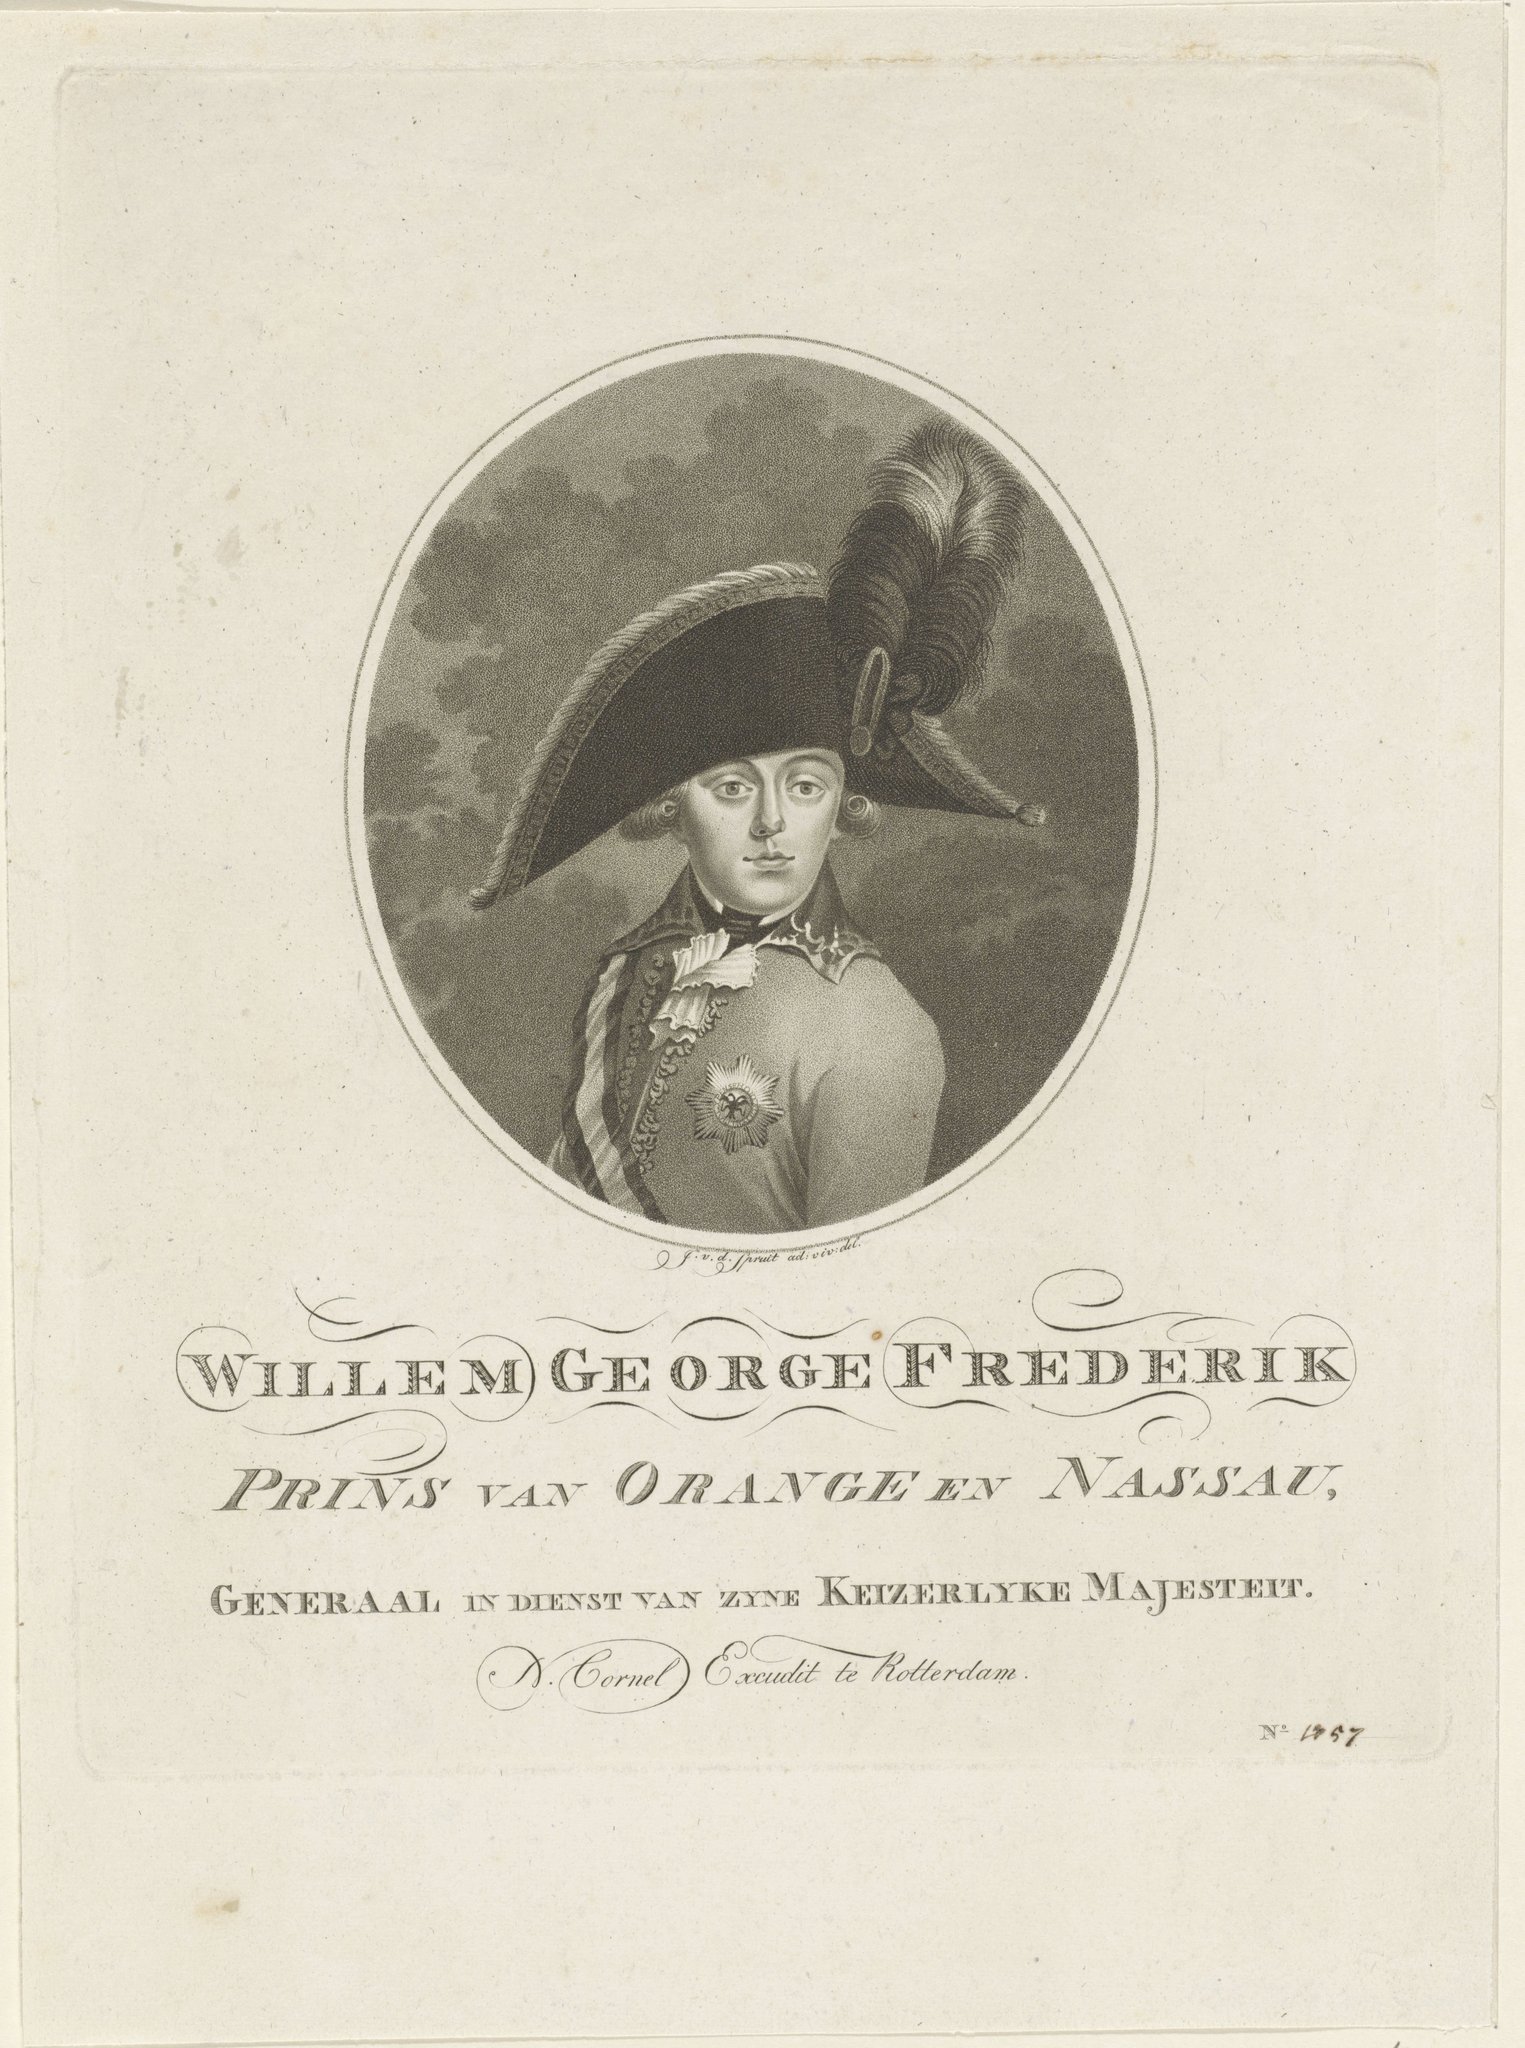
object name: print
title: Portret van Frederik, prins van Oranje-Nassau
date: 1790-1831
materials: paper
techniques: aquatint, engraving, etching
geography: rotterdam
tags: the hague, willem george frederik (prins van oranje-nassau), knighthood order (with name) - insignia of a knighthood order, e.g.: badge, chain (with name of order)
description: De hier vermelde titel verwijst naar de hoogst verkregen titel van de geportretteerde, niet per se naar de titel die de geportretteerde op deze voorstelling draagt.